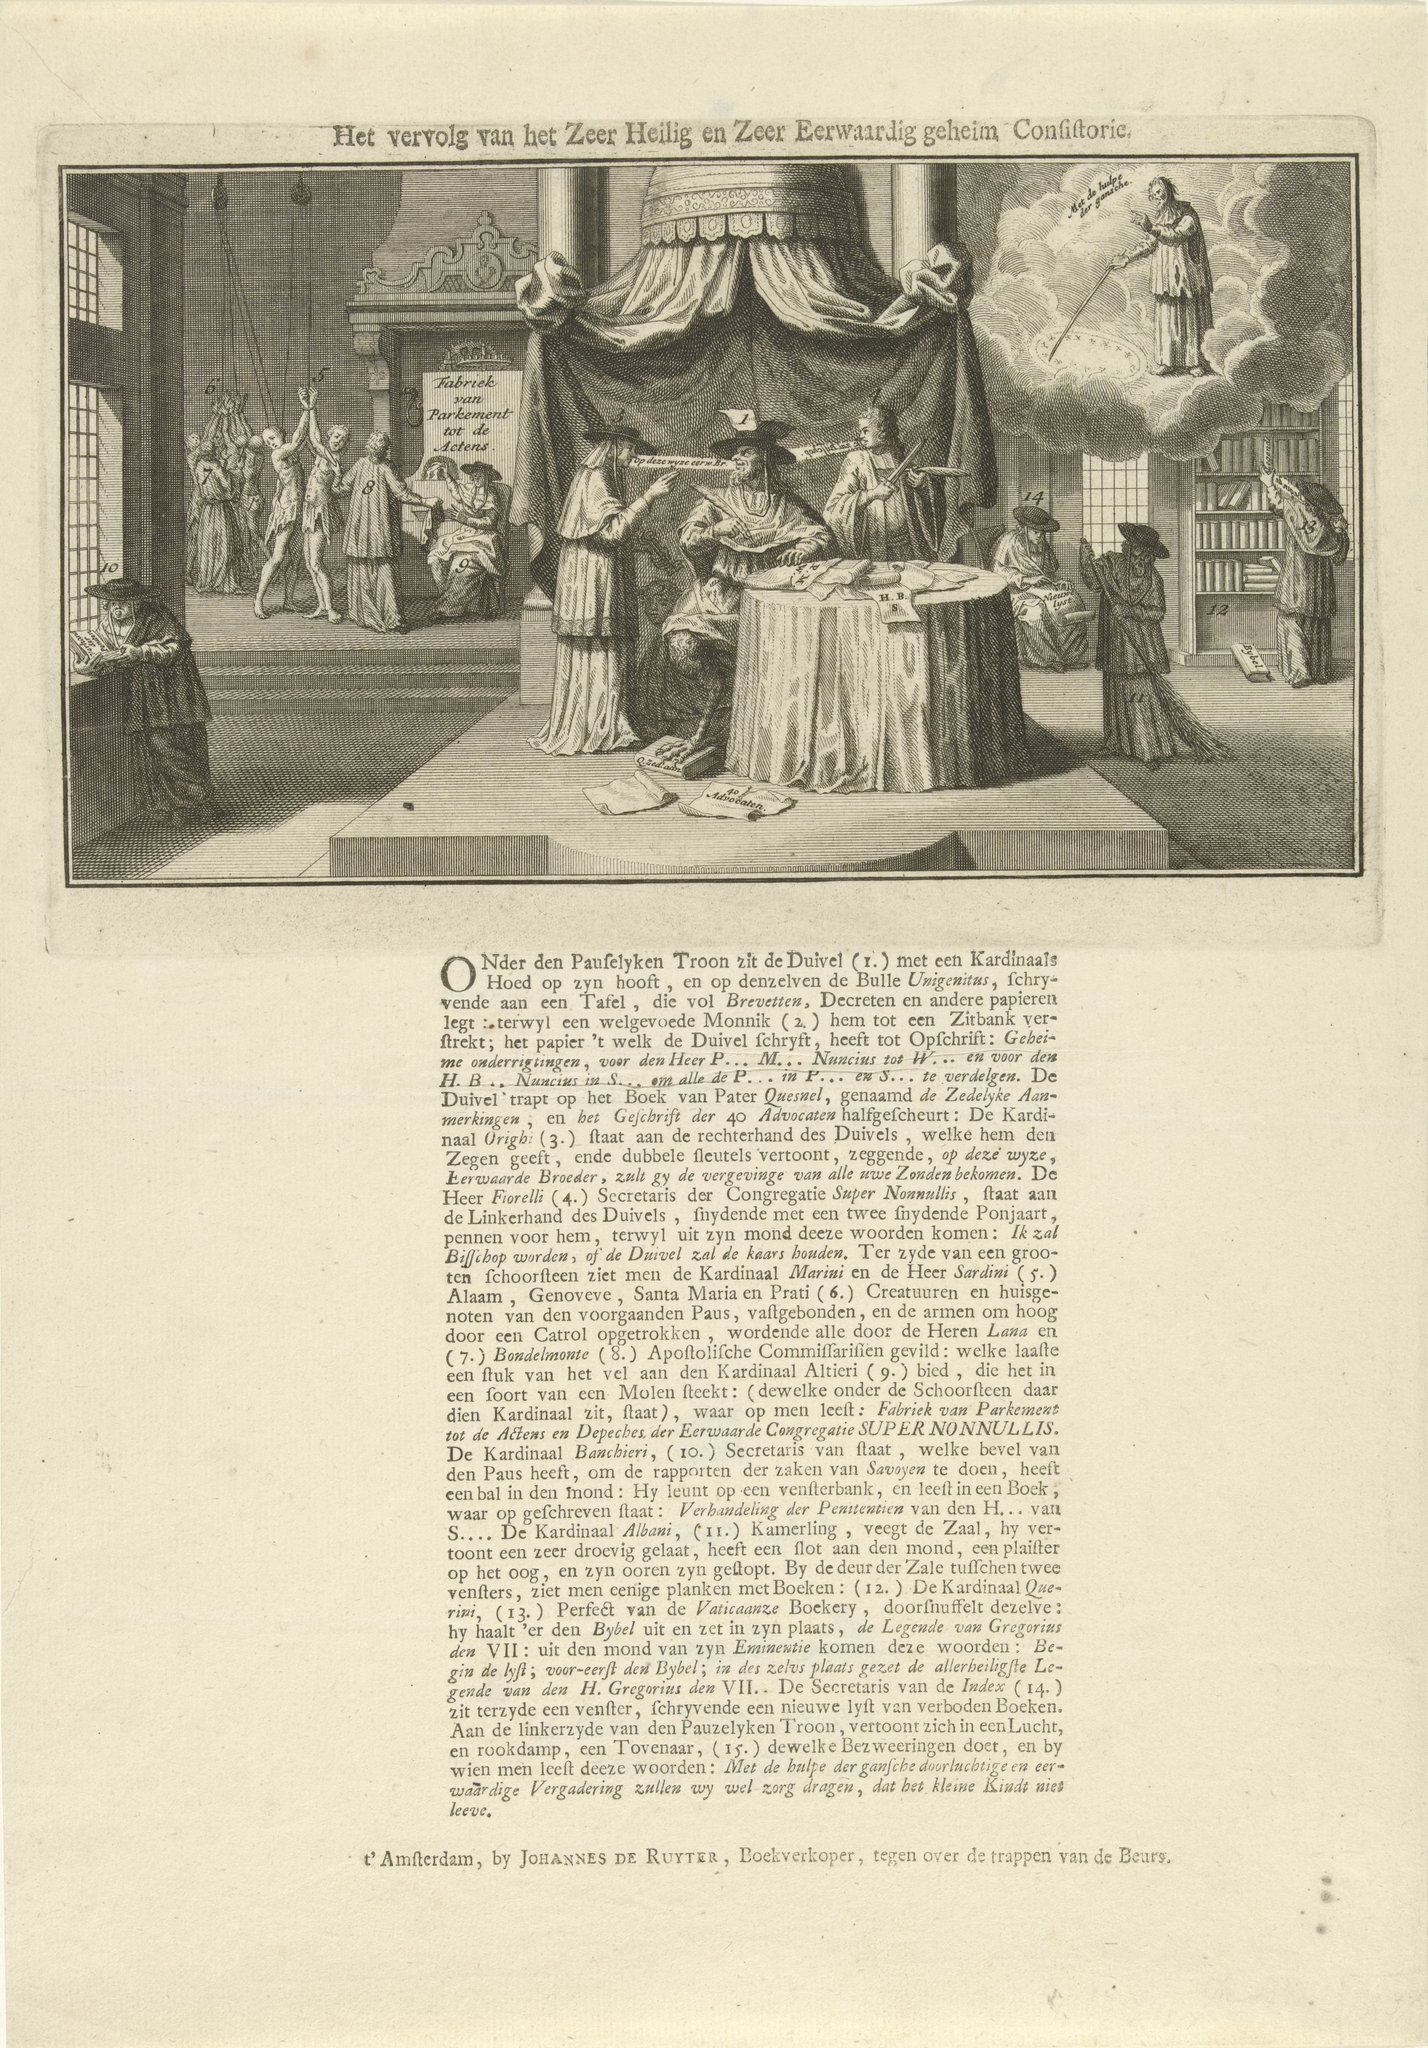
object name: print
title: Het vervolg van het Zeer Heilig en Zeer Eerwaardig geheim Consistorie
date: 1731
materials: paper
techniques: etching, letterpress printing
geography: amsterdam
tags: (aspects of) christian religion or the church (as institution) ridiculed, criticized, or caricaturized, activities of devil(s)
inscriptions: collector's mark: Lugt 2760, collector's mark: Lugt 2166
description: Spotprent met de duivel op de pauselijke troon, met om hem heen kardinalen die allerlei plannen beramen, waaronder de bul Unigenitus en de vervolgingen in Savoye, 1731. Op het blad onder de plaat de verklaring van de cijfers 1-14 in het Nederlands.